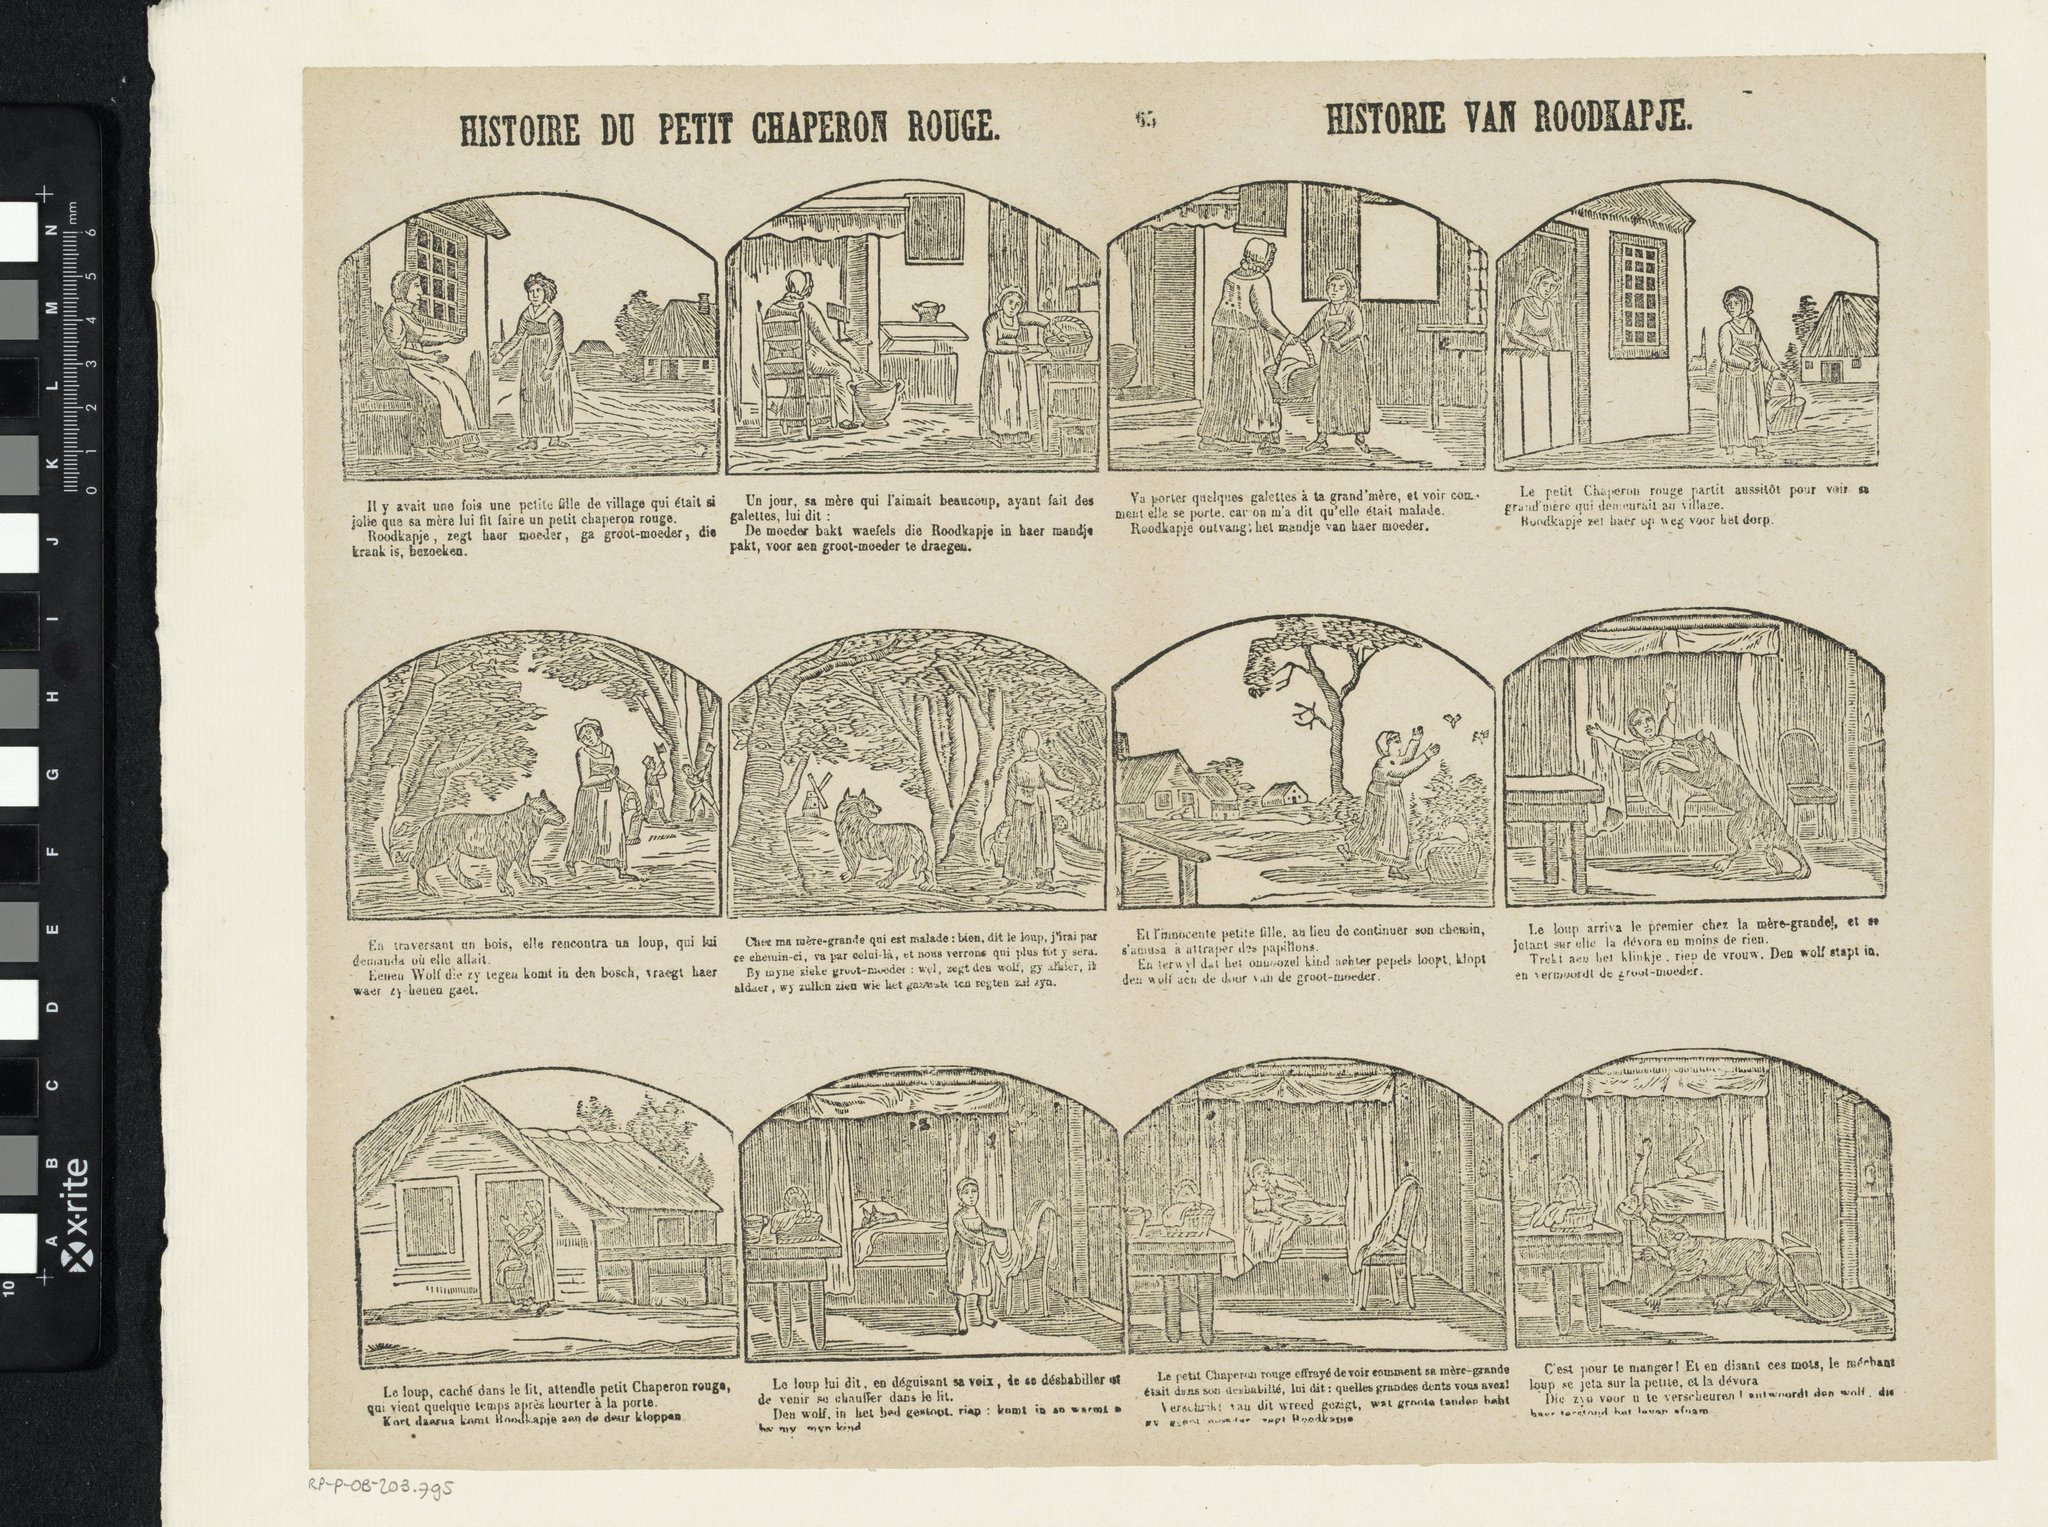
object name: print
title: Histoire du petit Chaperon Rouge / Historie van Roodkapje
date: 1827-1894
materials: paper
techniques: letterpress printing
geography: schaarbeek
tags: tales and fairy tales: little red riding-hood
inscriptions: collector's mark: Lugt 2760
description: Blad met 12 voorstellingen uit het sprookje van Roodkapje. Onder elke afbeelding een onderschrift in het Frans en in het Nederlands. Genummerd midden boven: 65.